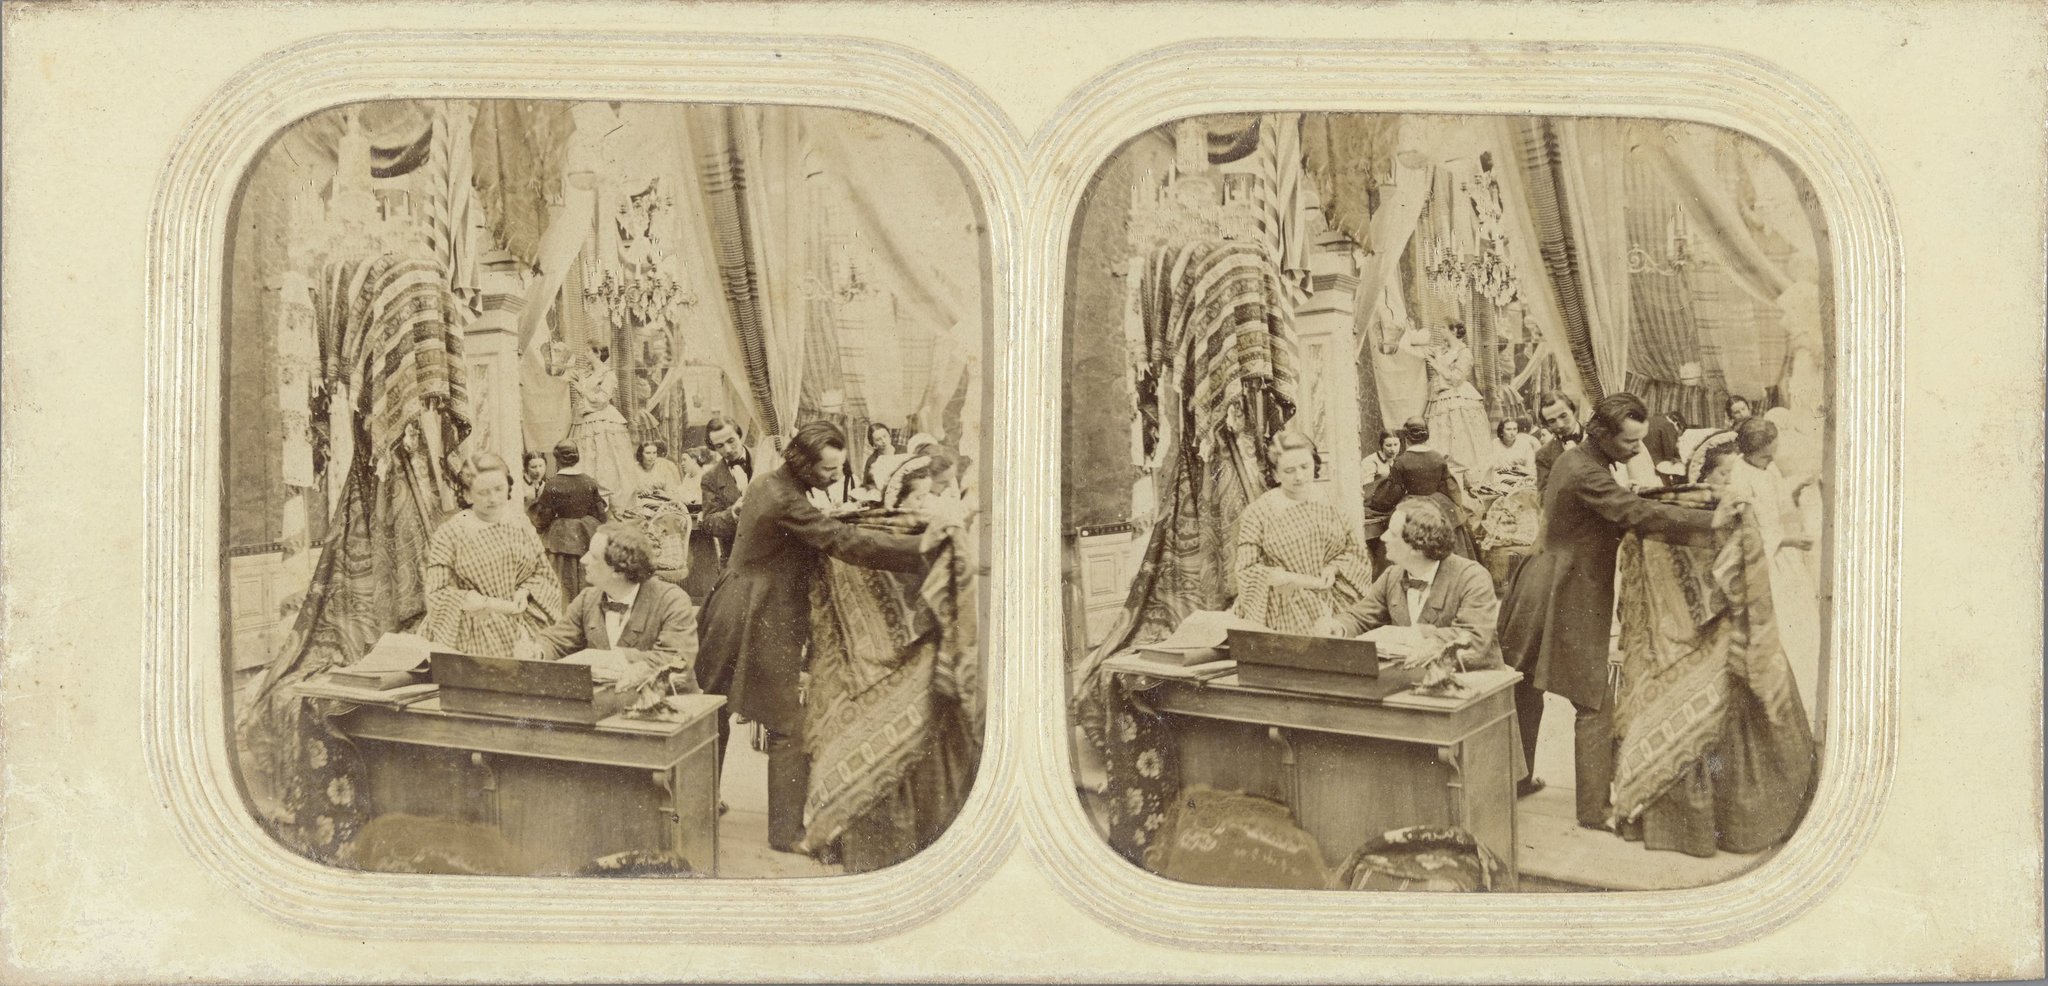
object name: tissue stereograph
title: Klanten en verkopers in een stoffenzaak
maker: Anonymous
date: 1860-1880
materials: cardboard, paper, photographic support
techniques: albumen print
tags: shop, store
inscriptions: inscription: ‘1009 uv ijs’